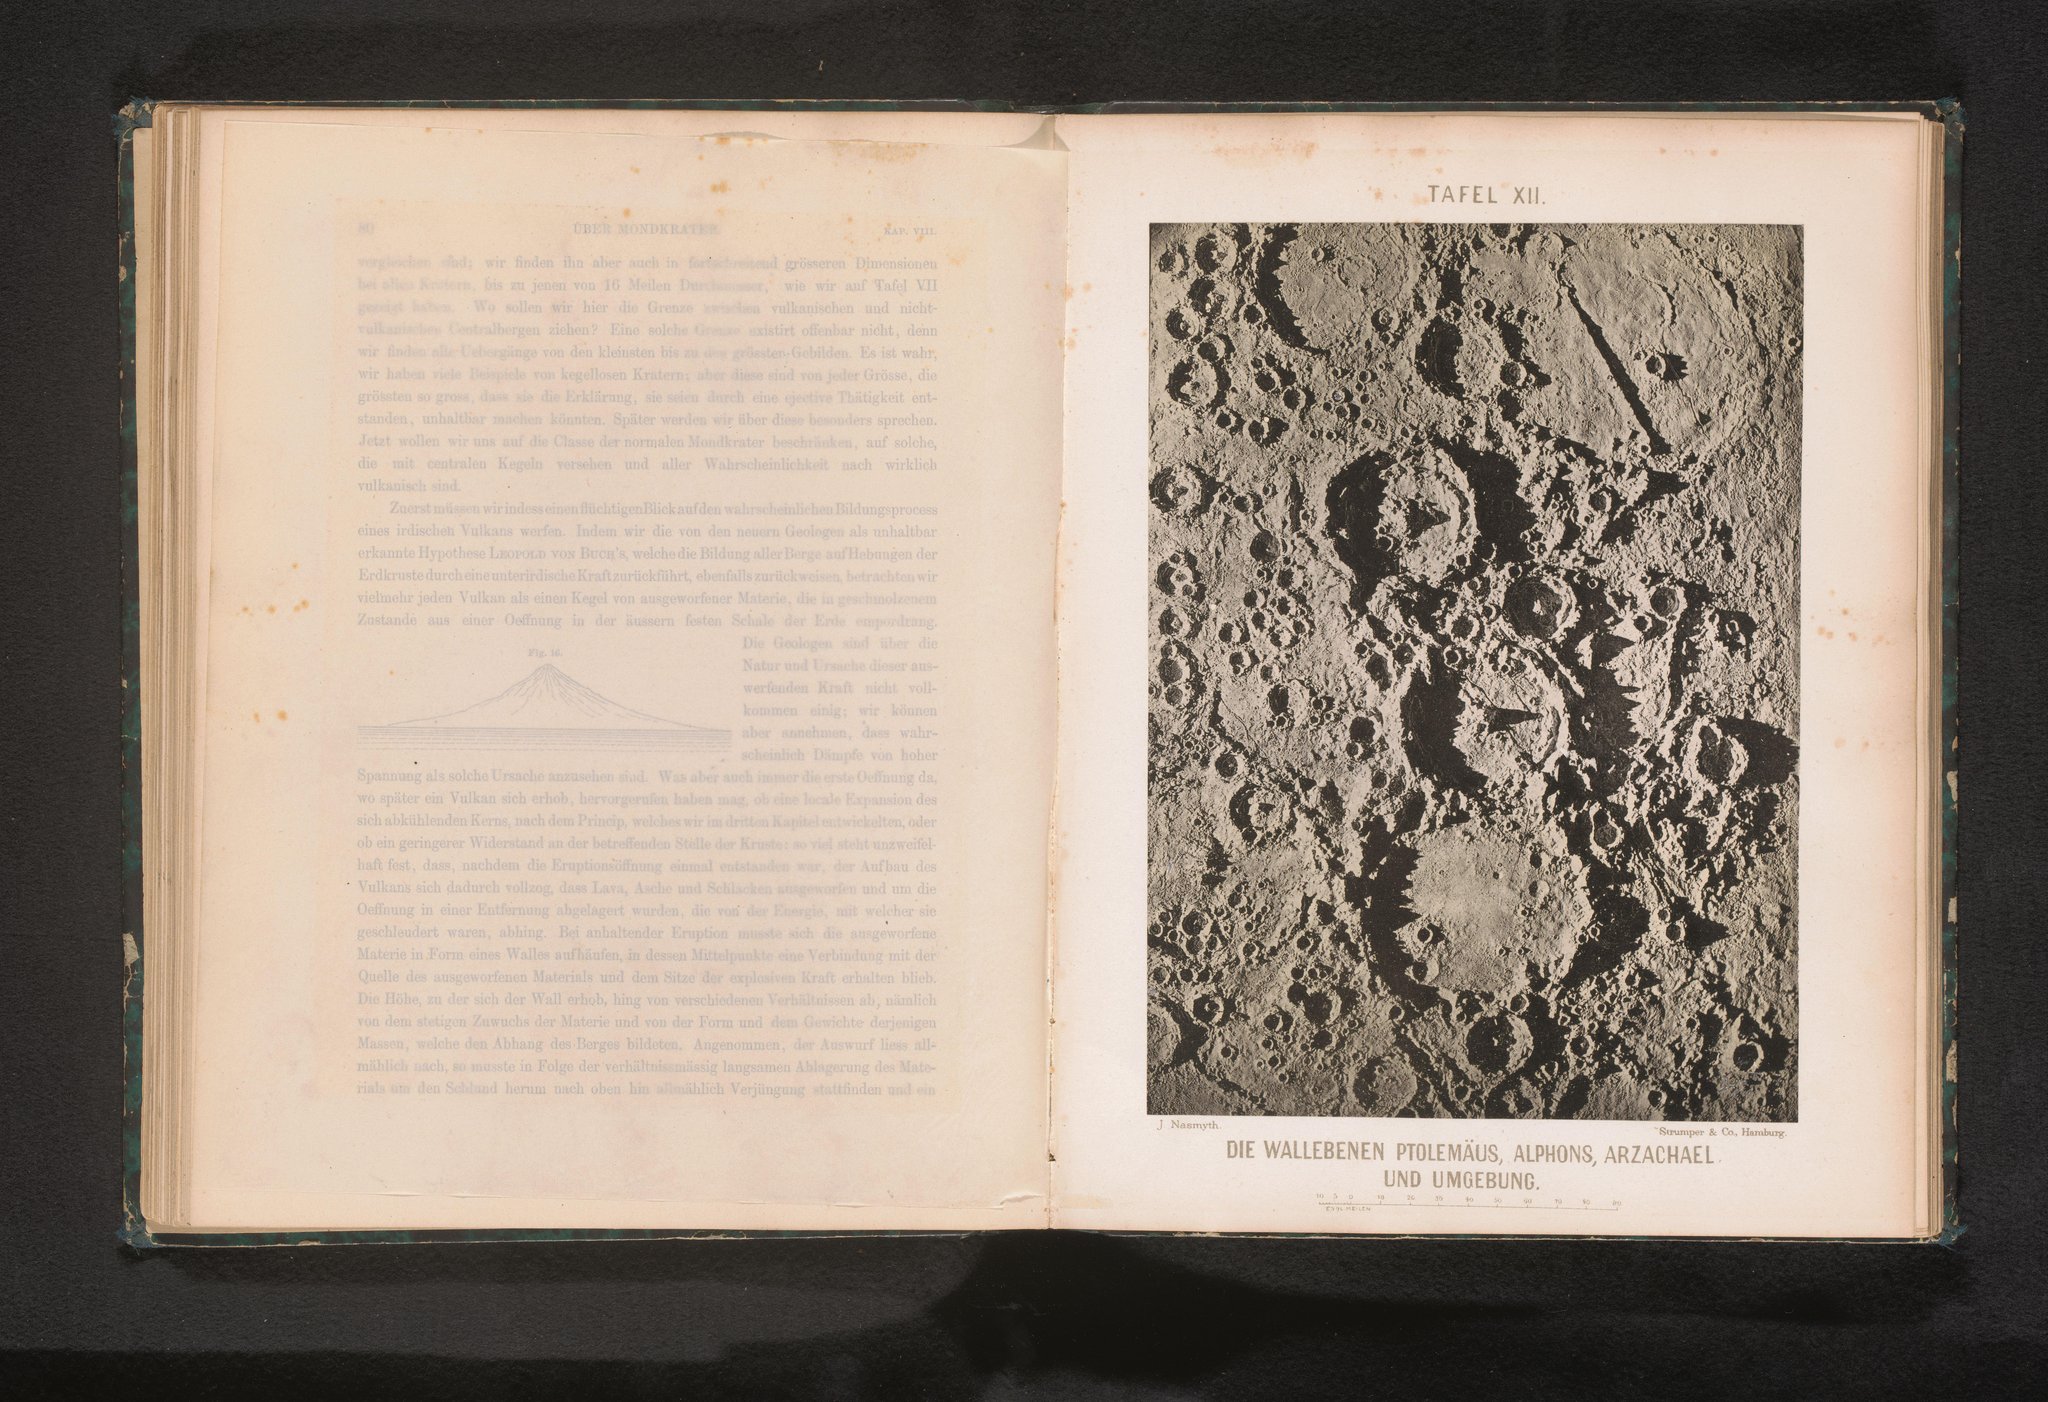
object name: page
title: Die Wallebenen Ptolemäus, Alphons, Arzachael und Umgebung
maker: james nasmyth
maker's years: 1808-1890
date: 1863-1873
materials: paper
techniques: photograph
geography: hamburg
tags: surface of the moon, moon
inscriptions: number: ‘Tafel XII.’